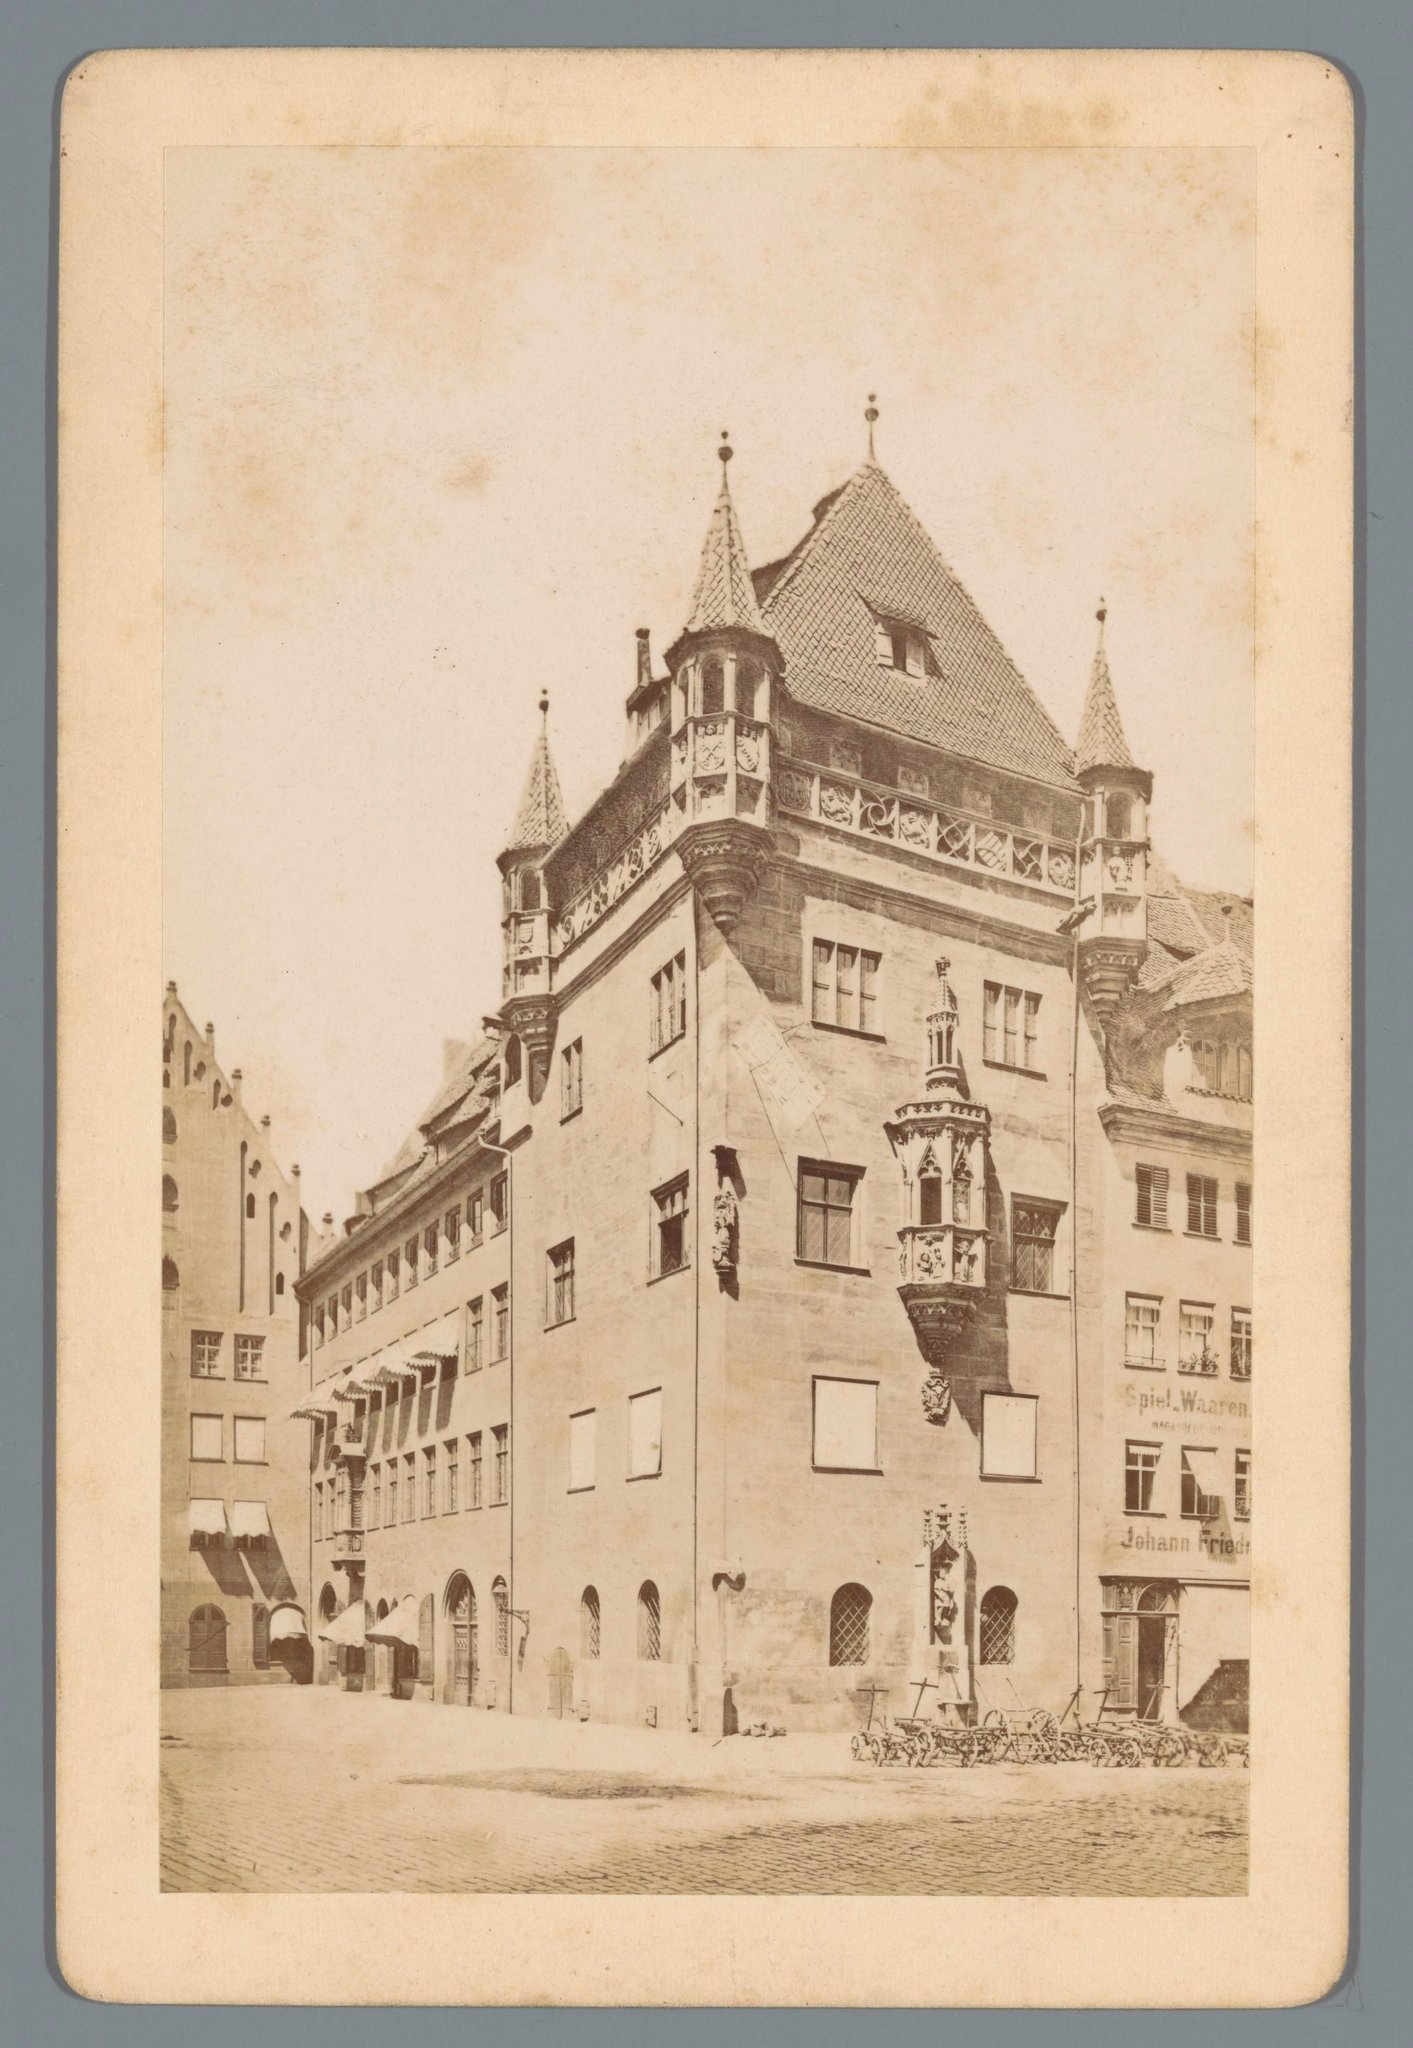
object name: cabinet photograph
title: Het Nassau-huis in Neurenberg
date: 1863-1898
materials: cardboard, photographic support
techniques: albumen print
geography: nuremberg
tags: housing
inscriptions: number: ‘5.’